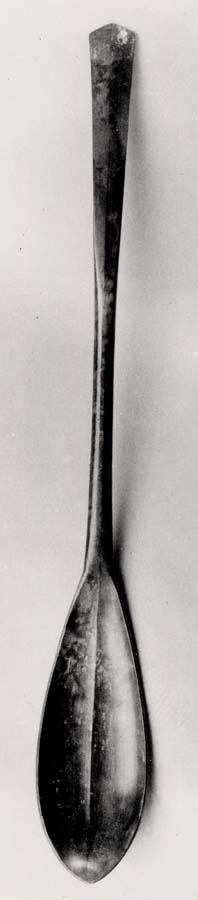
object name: spoon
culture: korean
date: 918-1392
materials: bronze